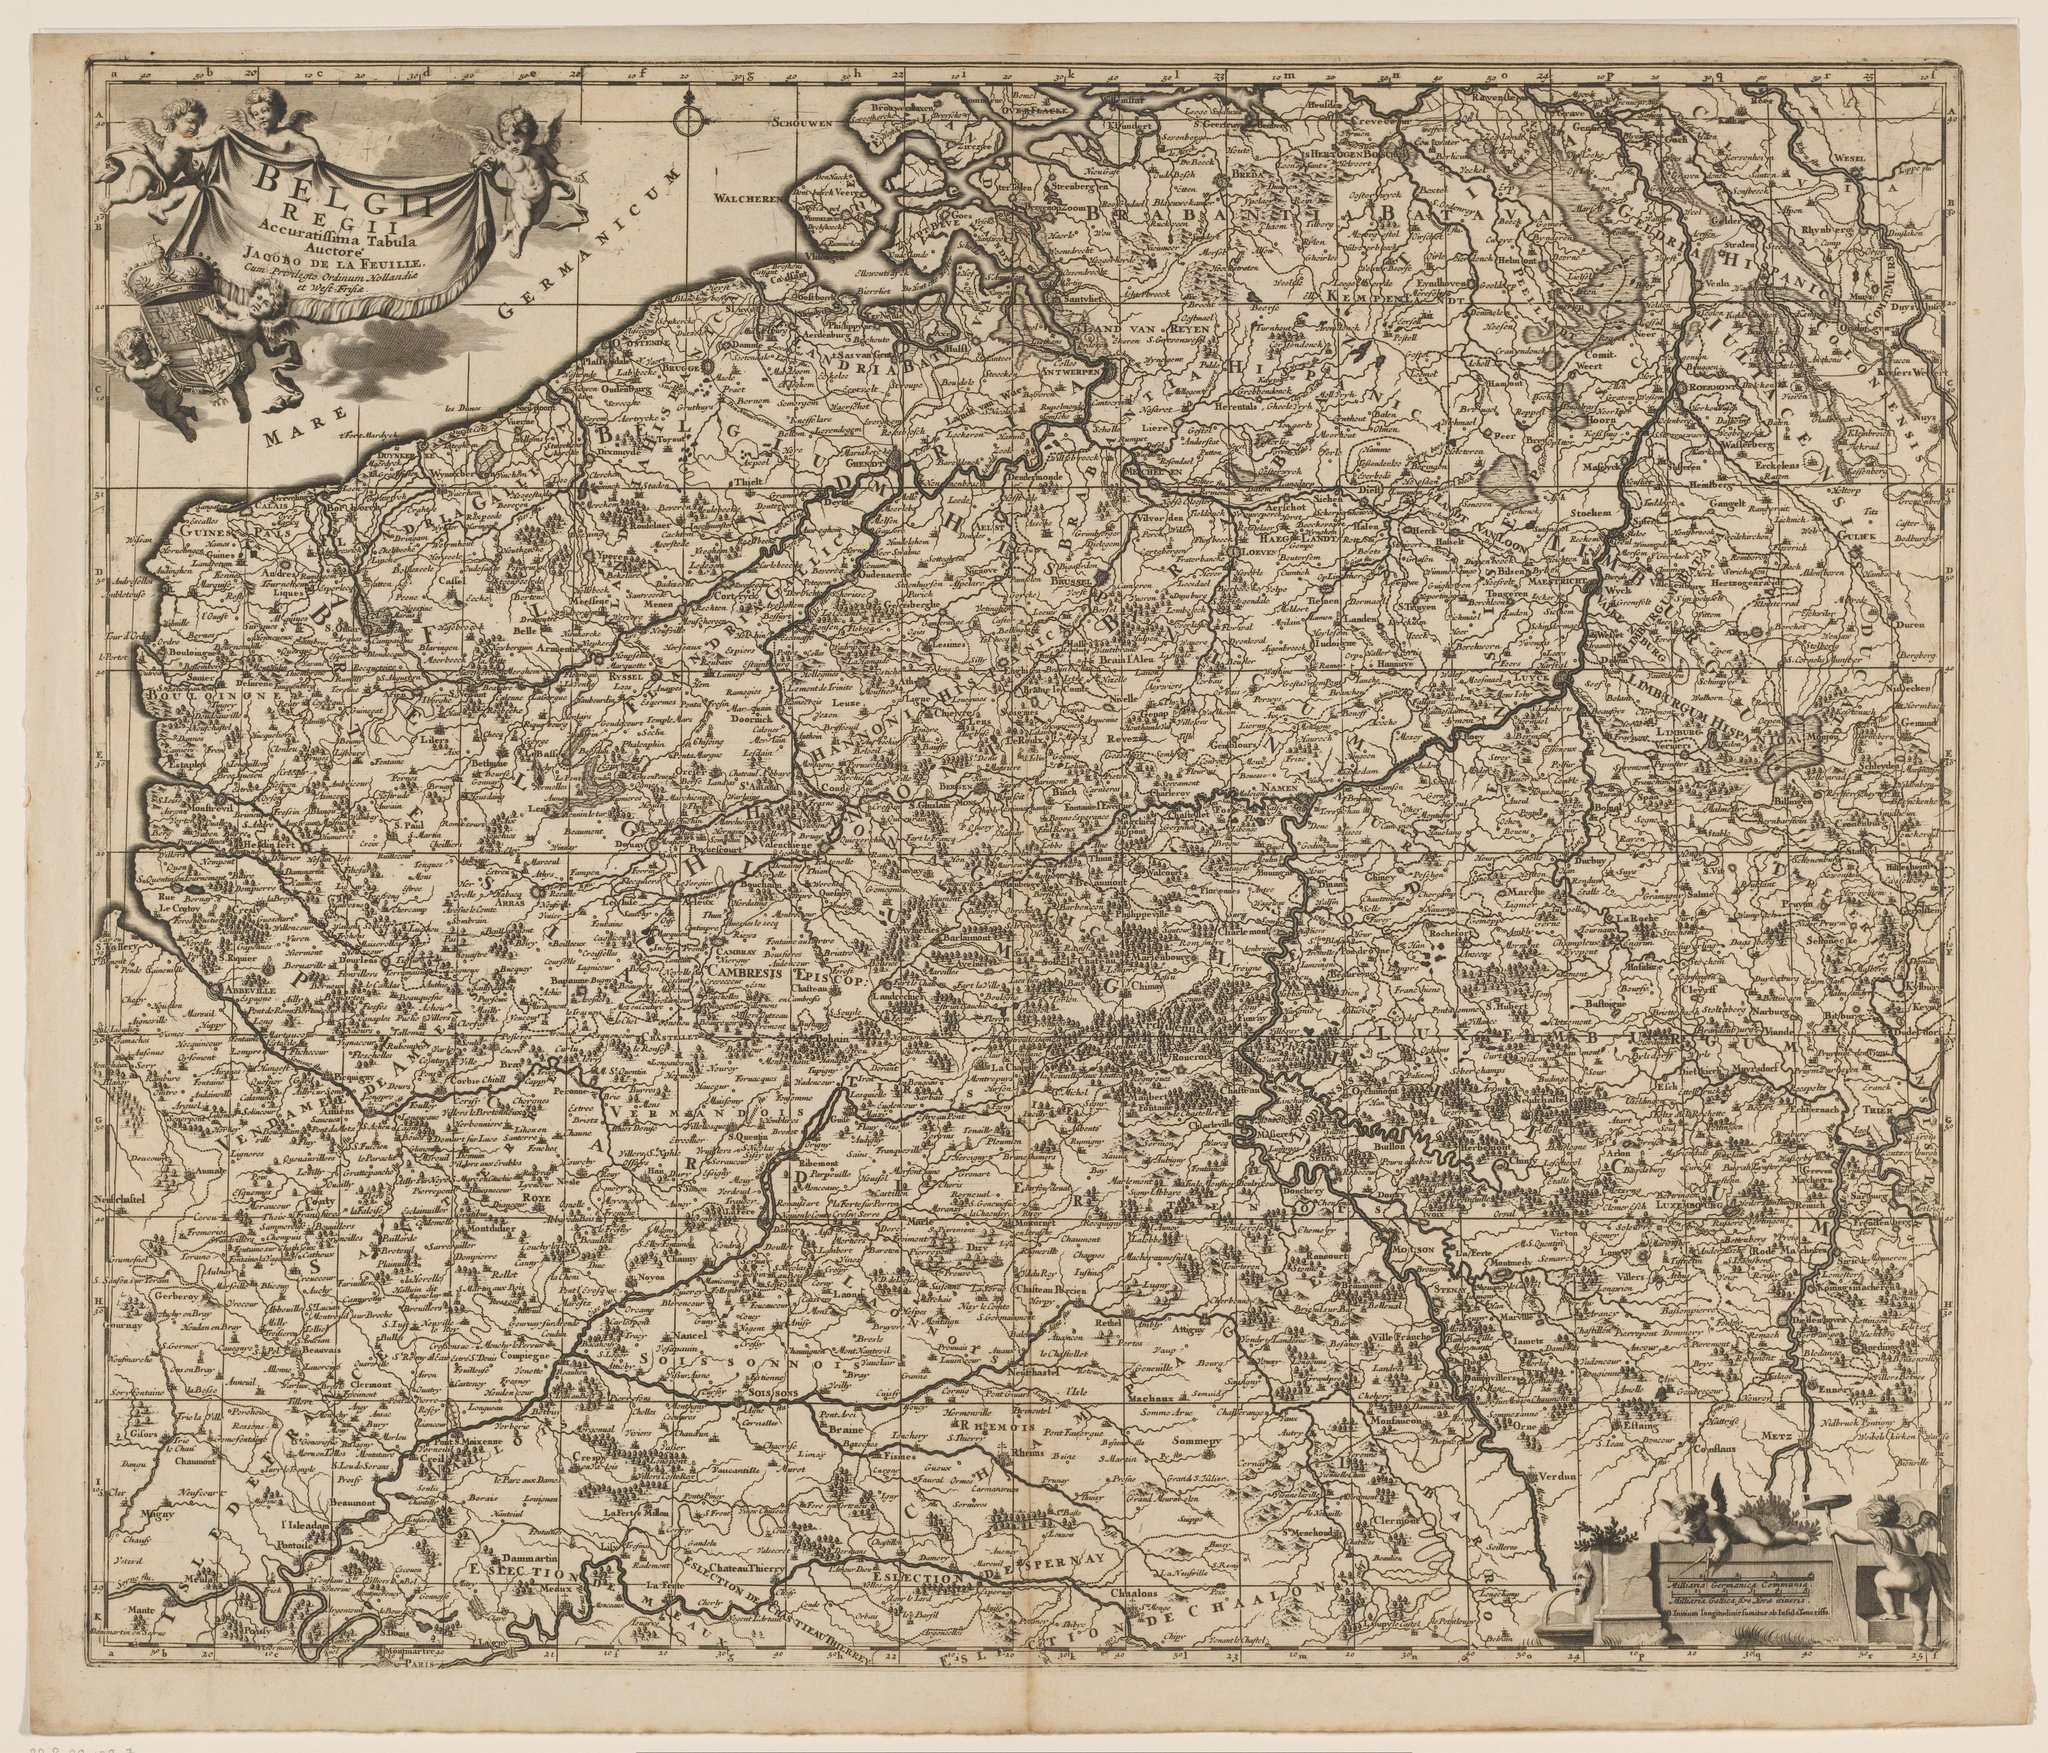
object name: print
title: Kaart van de Zuidelijke Nederlanden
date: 1678-1719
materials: paper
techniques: engraving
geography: amsterdam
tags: maps of separate countries or regions, armorial bearing, heraldry, southern netherlands, belgium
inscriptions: collector's mark: Lugt 195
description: Kaart van de Zuidelijke Nederlanden. Linksboven de titelcartouche met daaromheen vijf putti, waarvan twee het wapen van de koning van Spanje dragen. Rechtsonder een cartouche met twee schaalstokken: 4 Milliaria Germanica Communia / 5 Milliaria Gallica sive Horae itineris. De kaart is voorzien van een zoekrooster en een gradenverdeling langs de randen.